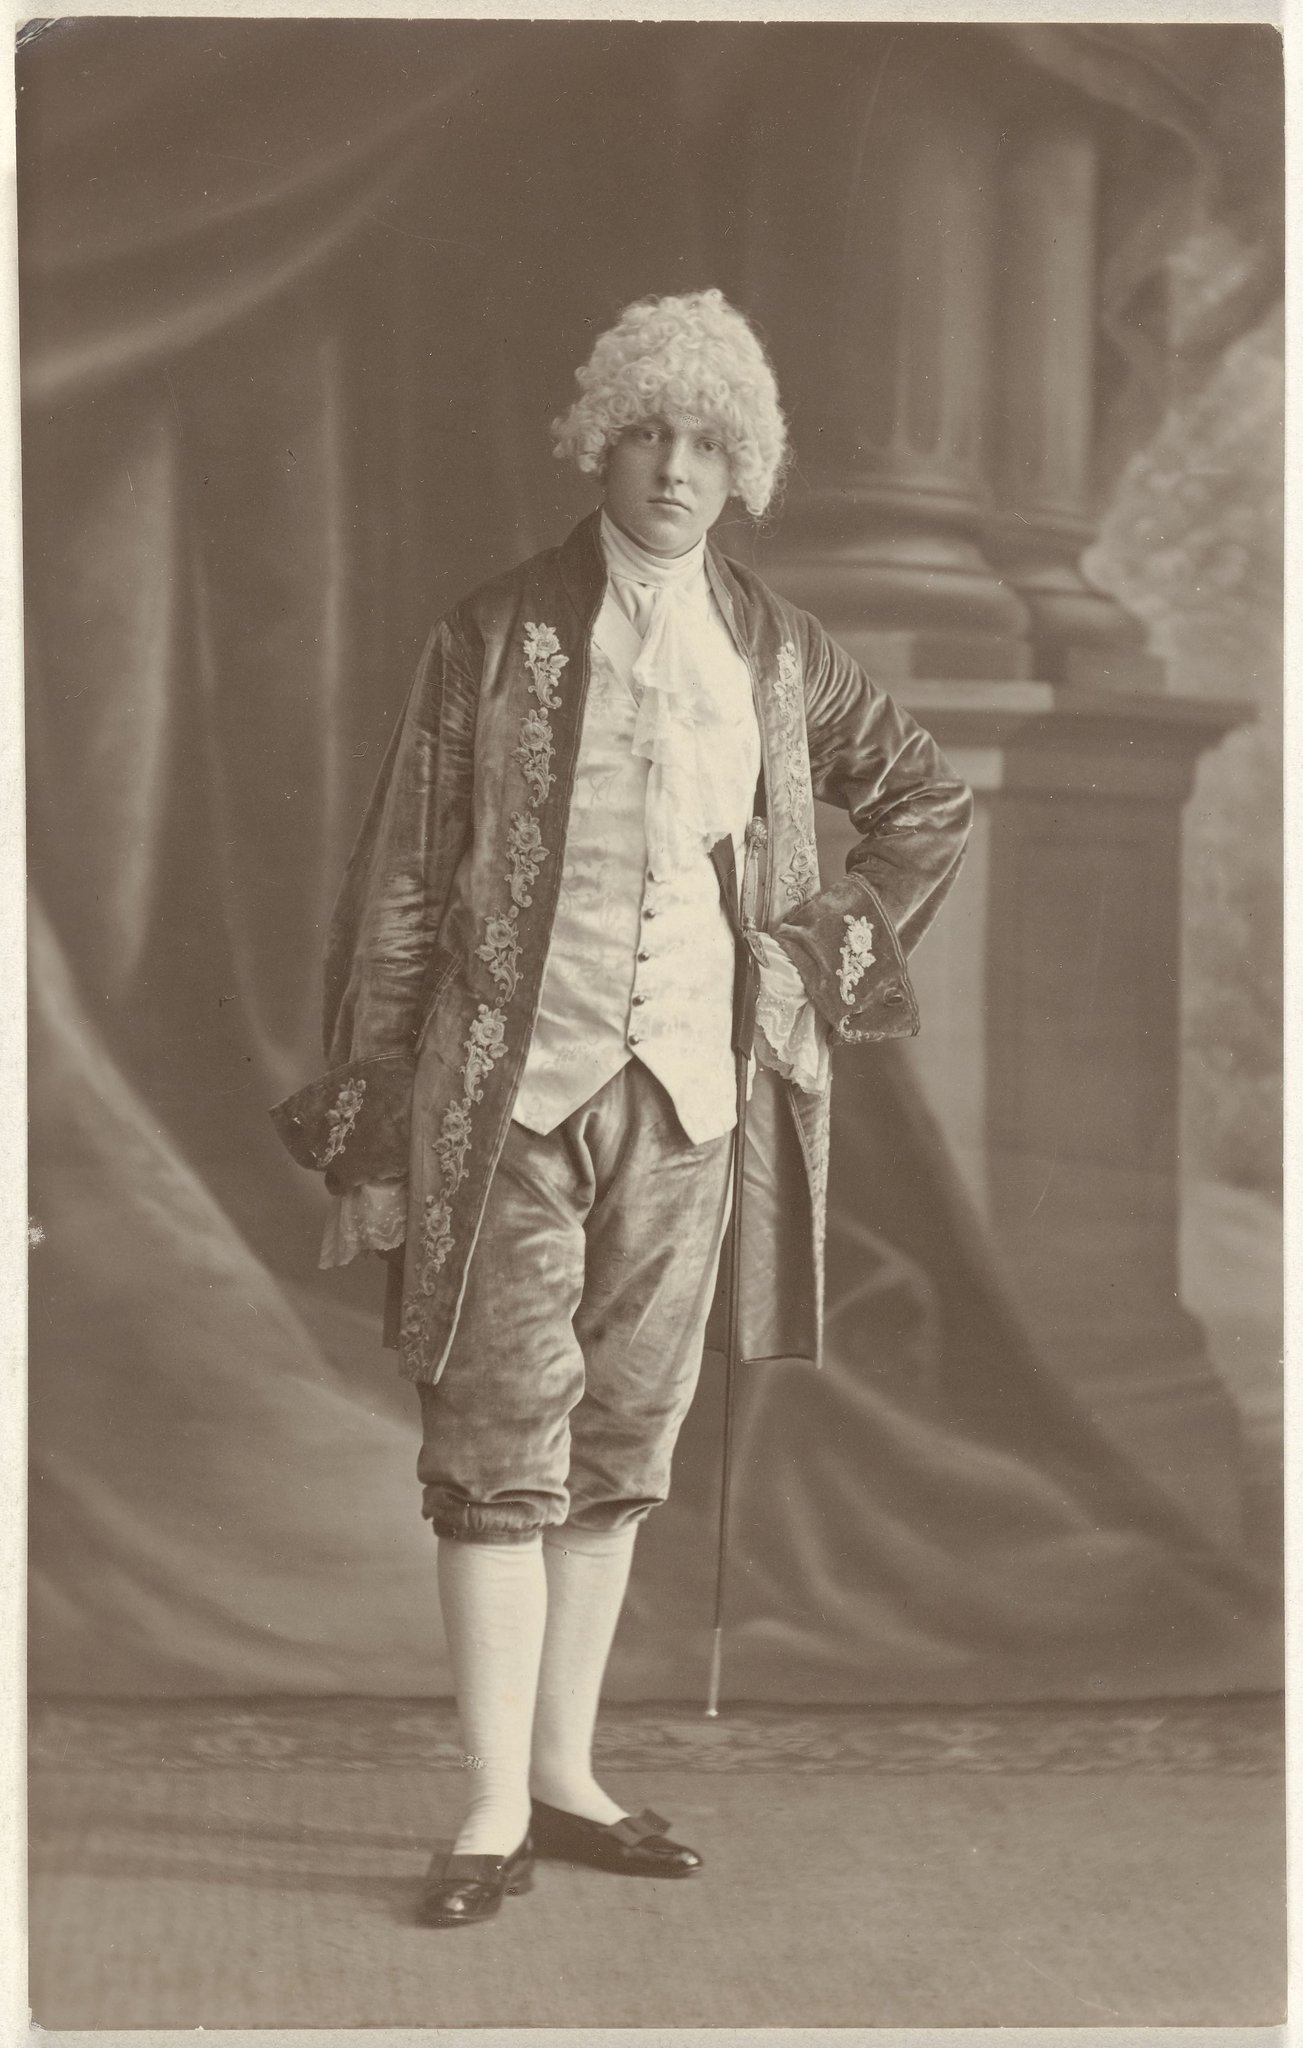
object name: photograph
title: Studioportret van een man in kostuum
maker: Anonymous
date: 1880-1920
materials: cardboard, photographic support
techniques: collodion silver print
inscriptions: name: ‘Bram en David’